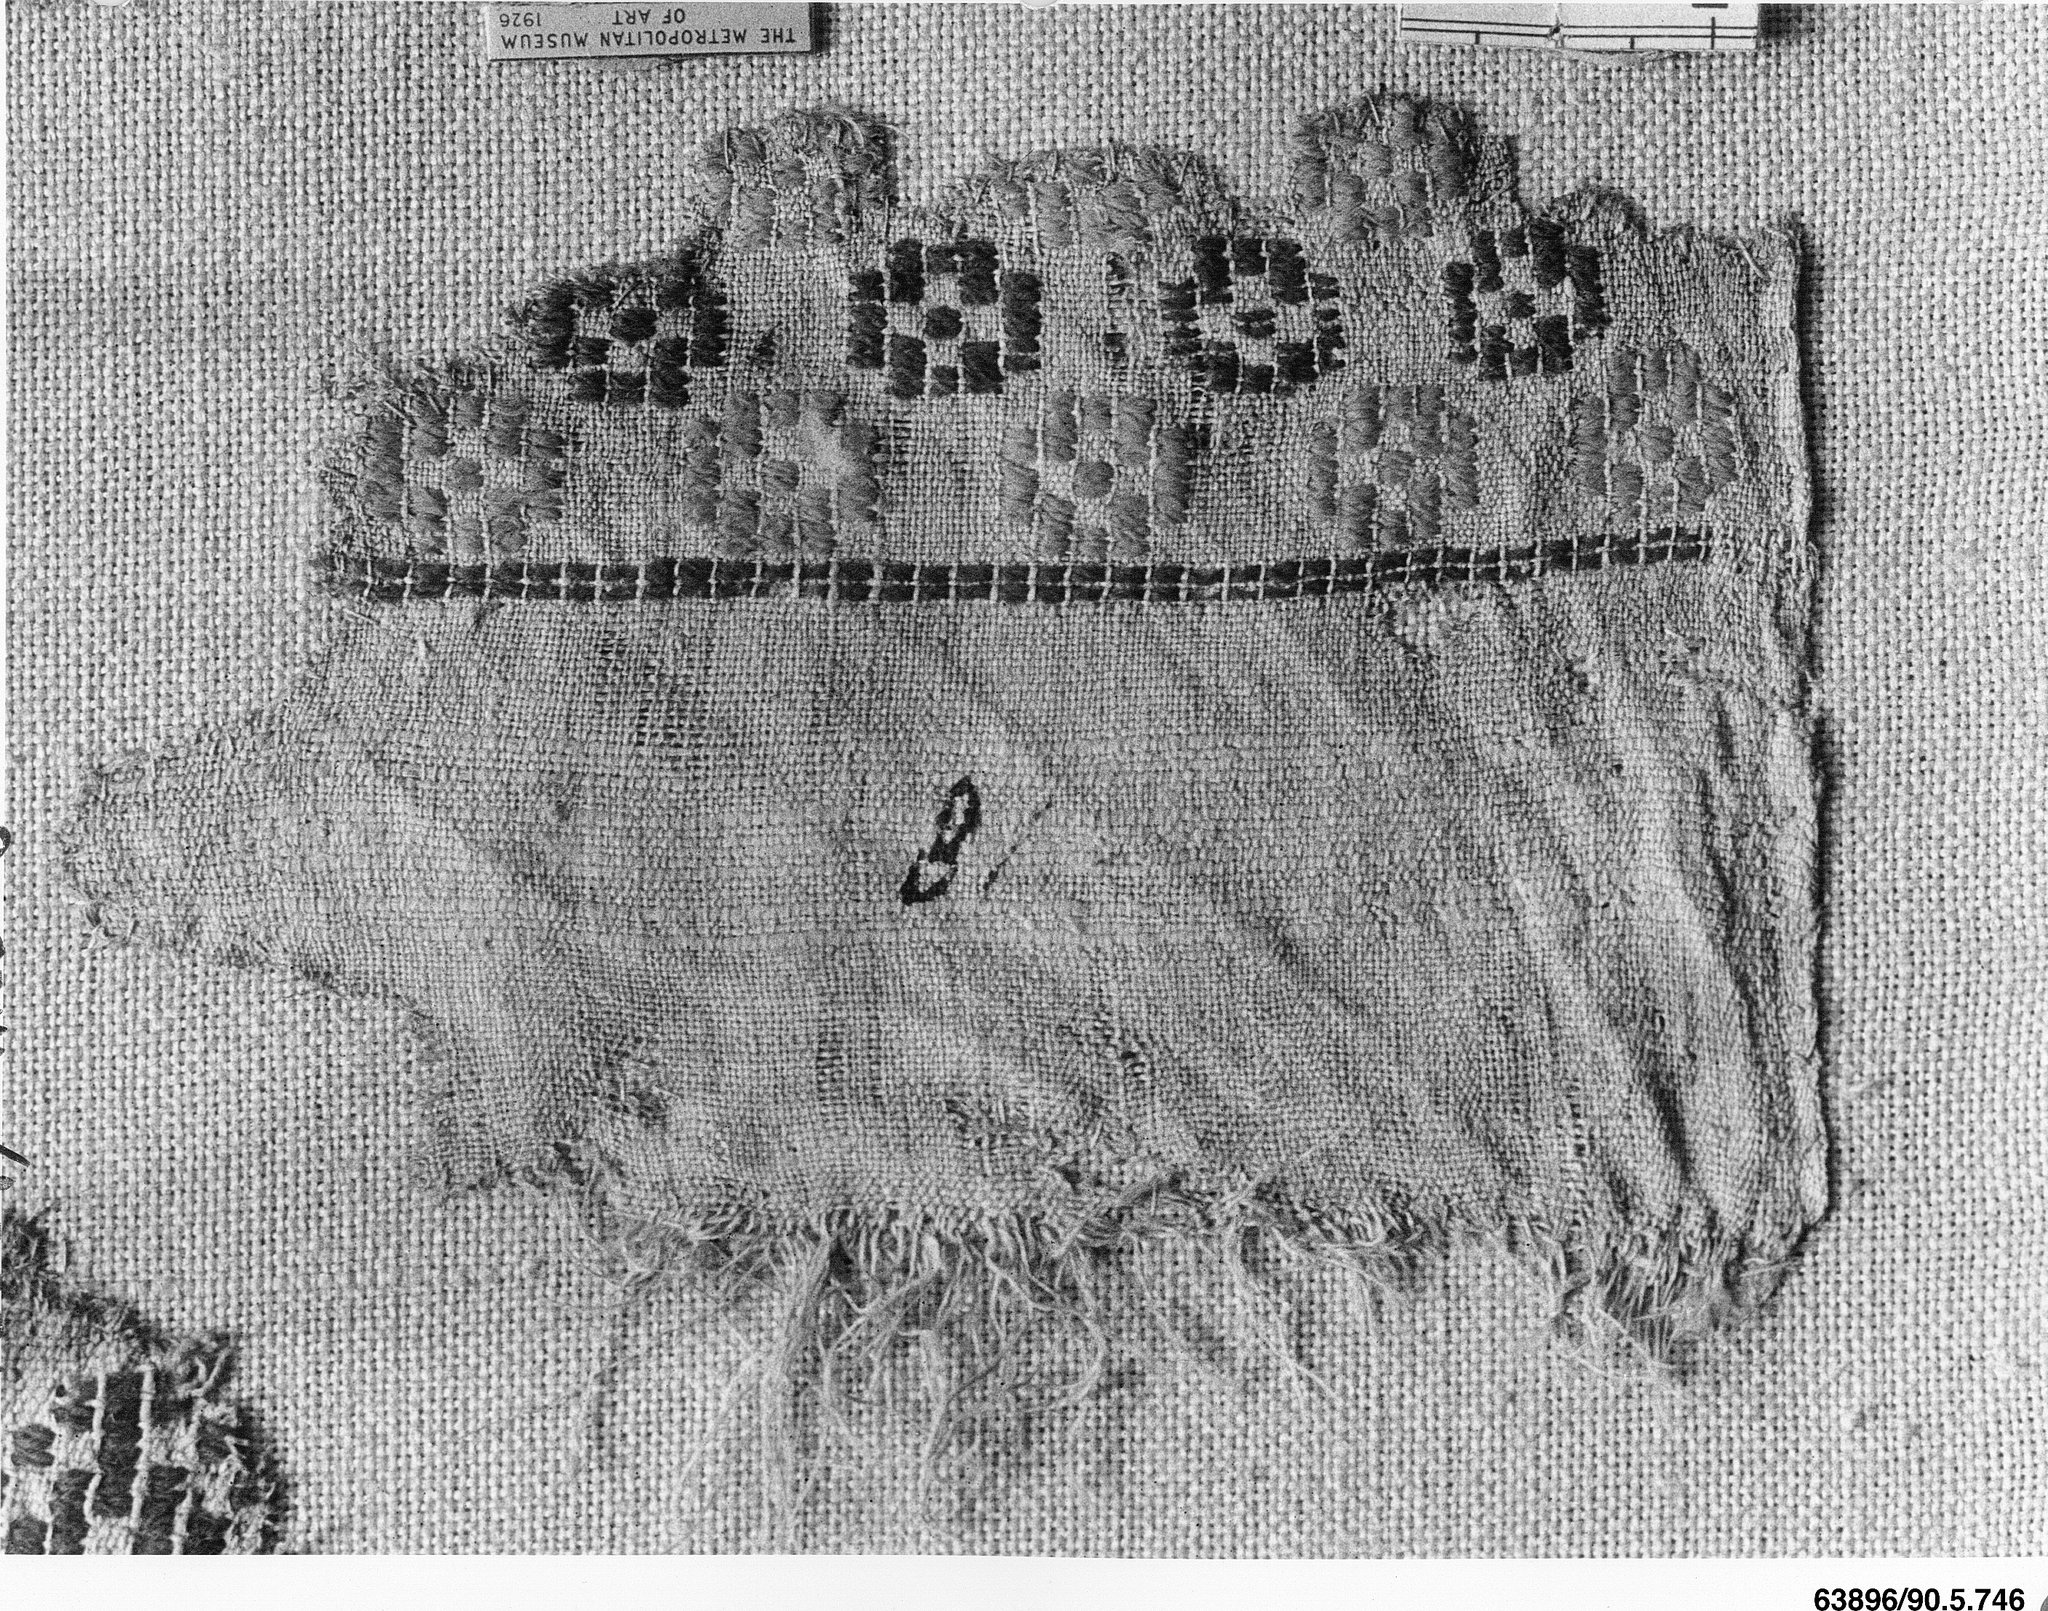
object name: textile fragment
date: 401-600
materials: linen, wool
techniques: brocade, weave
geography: egypt